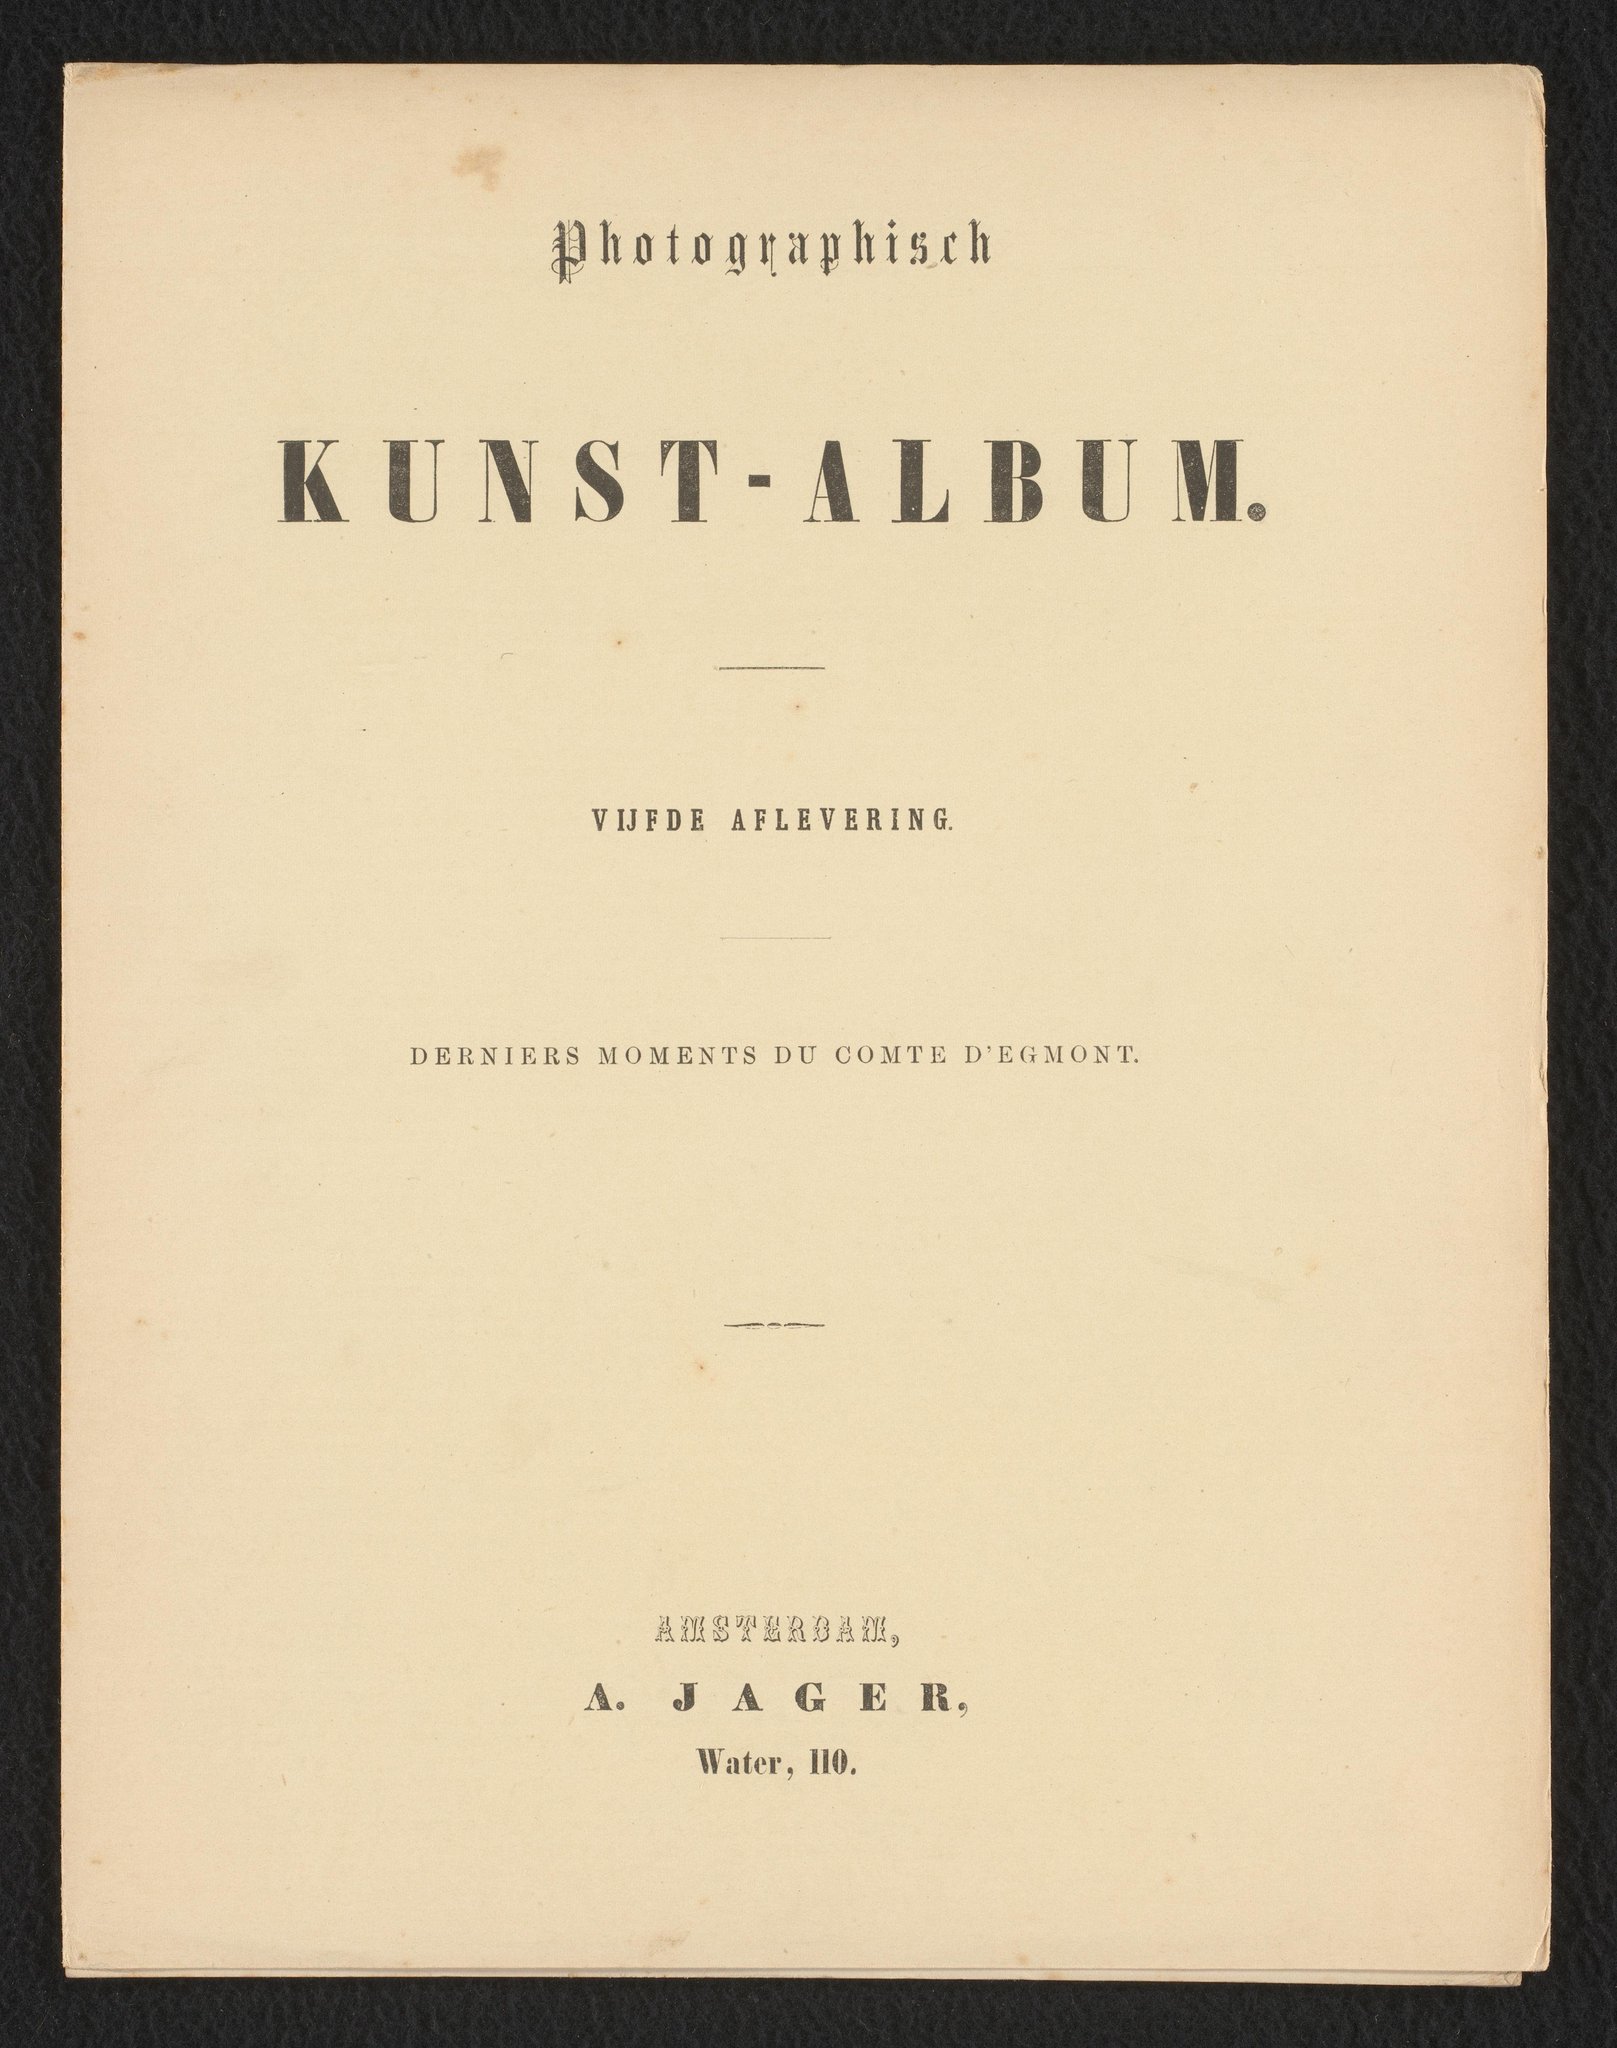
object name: wrapper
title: Vijfde aflevering. Derniers moments du comte d'Egmont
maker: andries jager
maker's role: publisher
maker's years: 1825-1905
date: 1860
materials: paper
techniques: printing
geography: amsterdam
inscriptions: address: ‘AMSTERDAM,/ A. JAGER,/ Water, 110.’, inscription: ‘DERNIERS MOMENTS DU COMTE D'EGMONT/ NAAR EENE SCHILDERIJ/ VAN/ L. GALLAIT.’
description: Deze omslag maakt deel uit van een omslag met twaalf fotoreproducties.